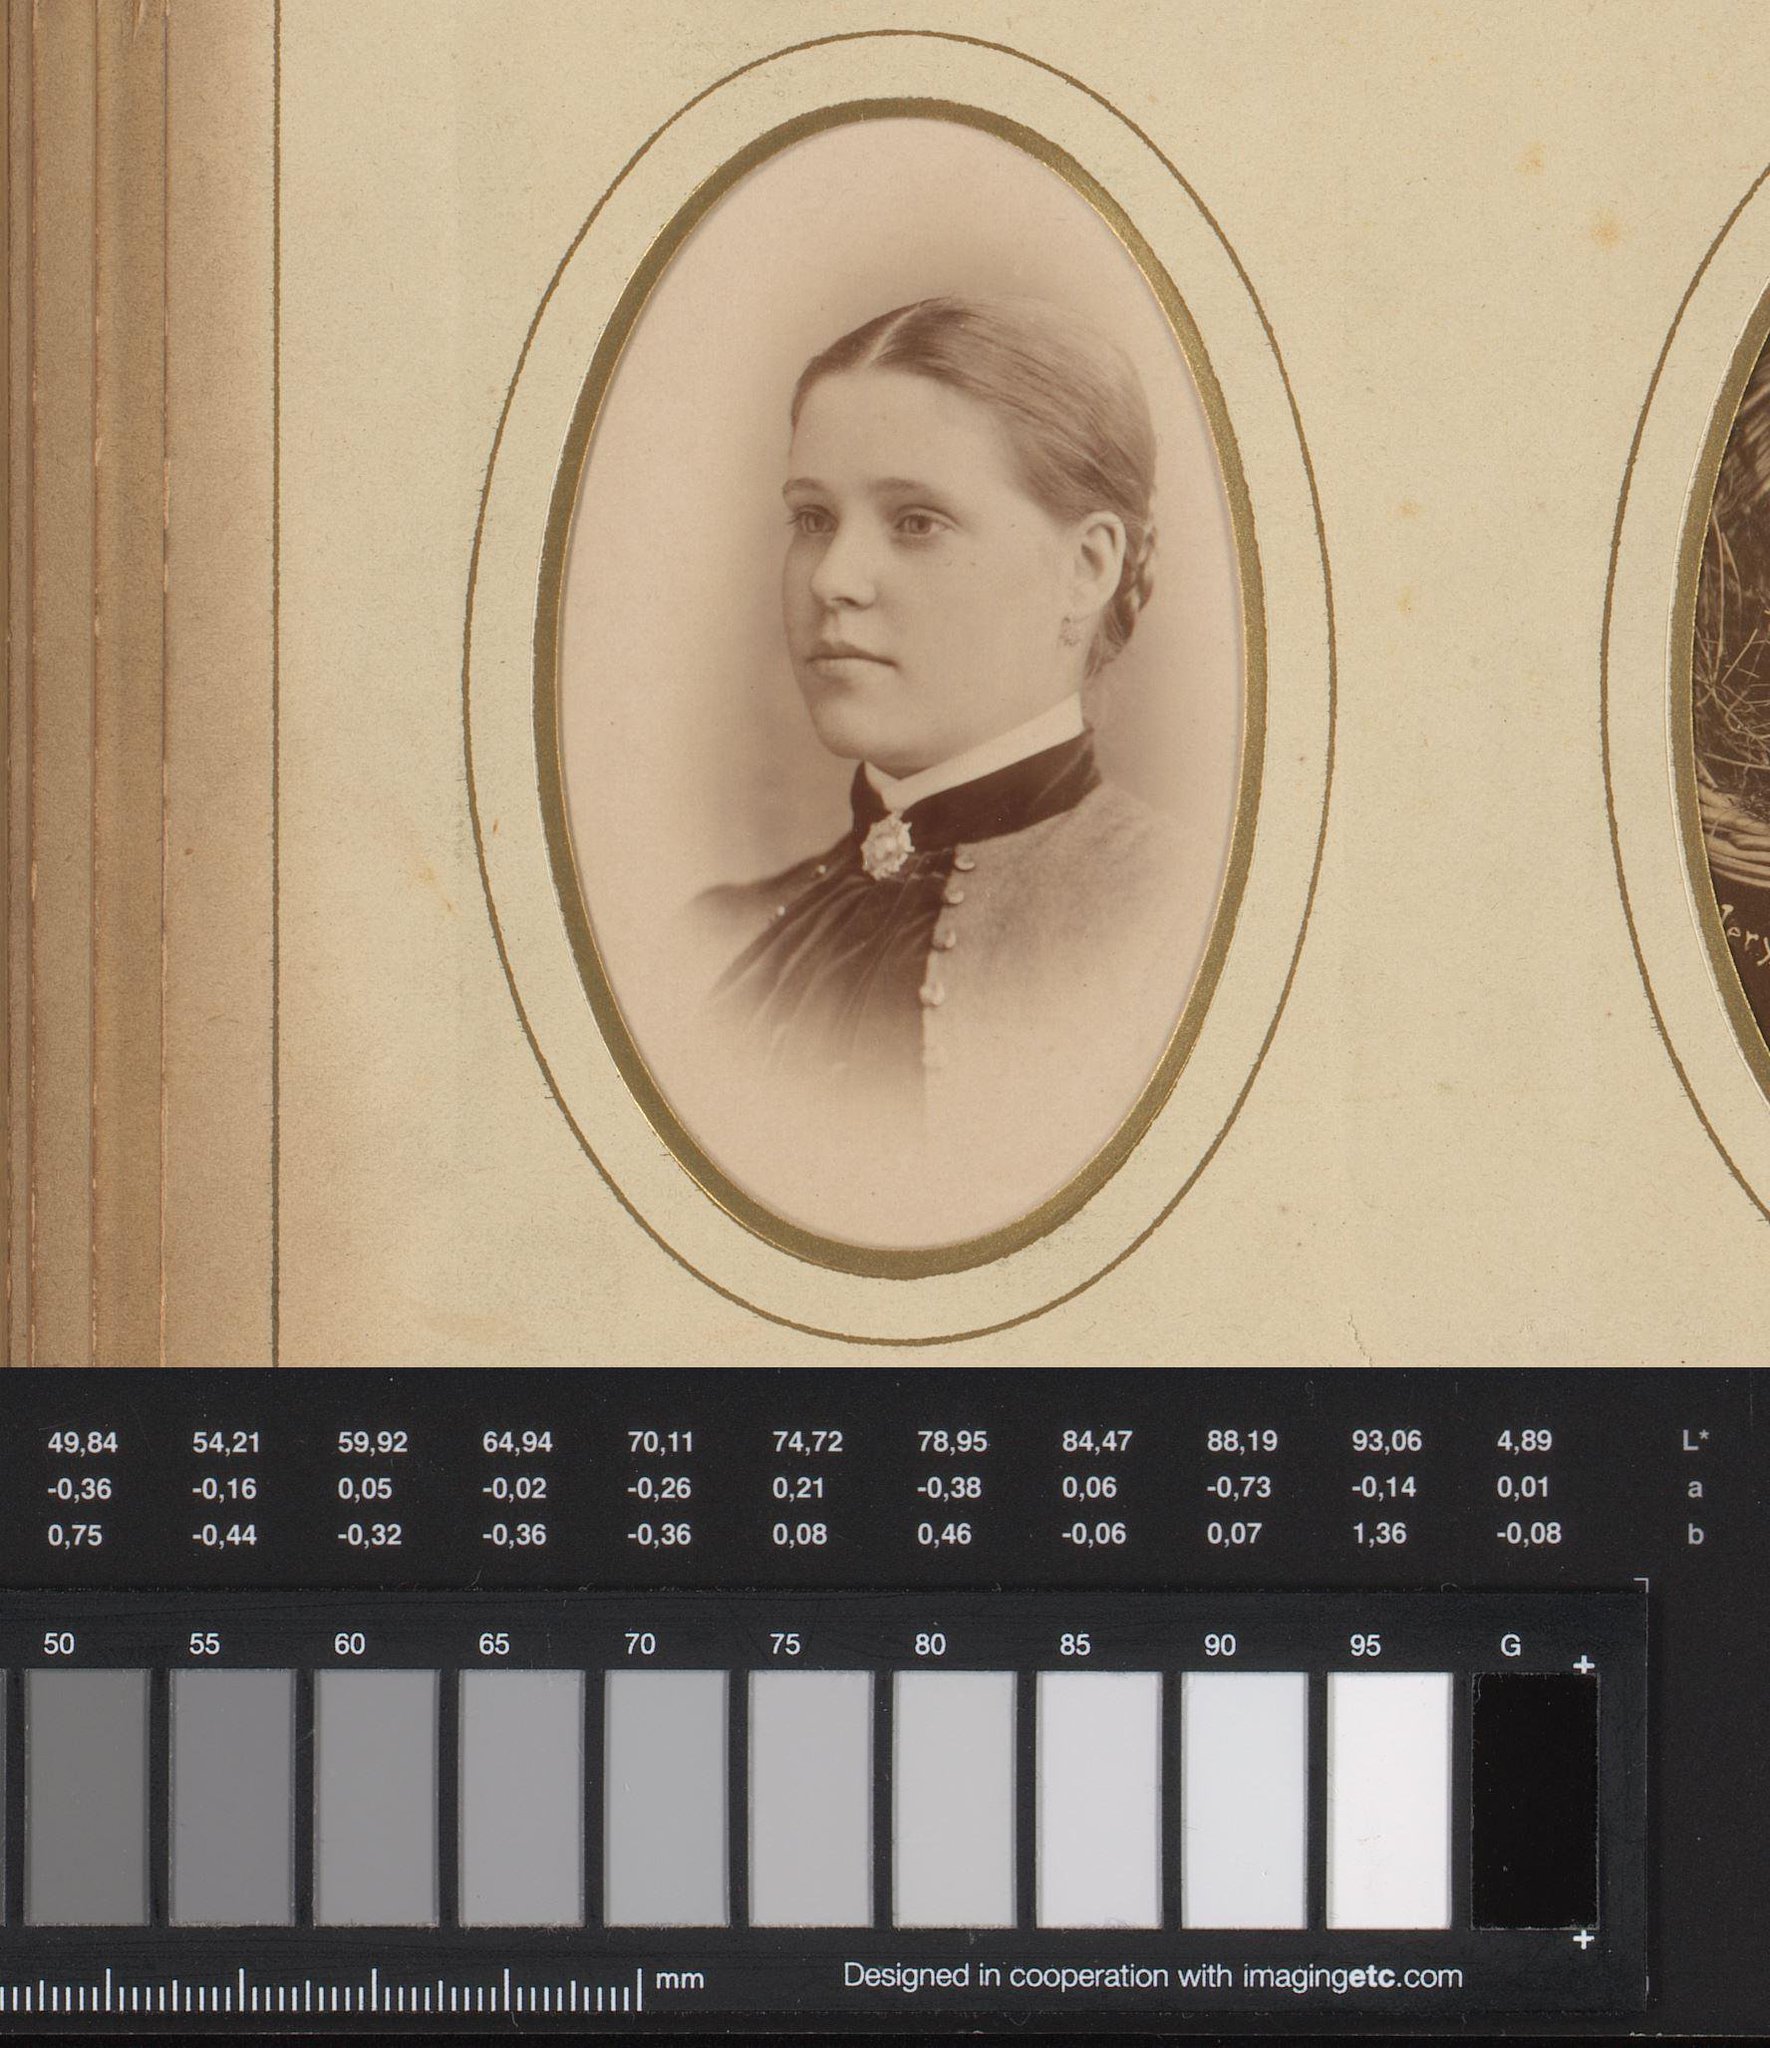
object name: carte de visite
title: Portret van een vrouw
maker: samuel barton mcclellan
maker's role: engineer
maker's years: 1857-1913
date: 1860-1900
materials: cardboard, photographic support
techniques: albumen print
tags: adult woman, historical persons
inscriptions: inscription: ‘S.B. McClellan/ Photographer/ Sidcup/ Kent’